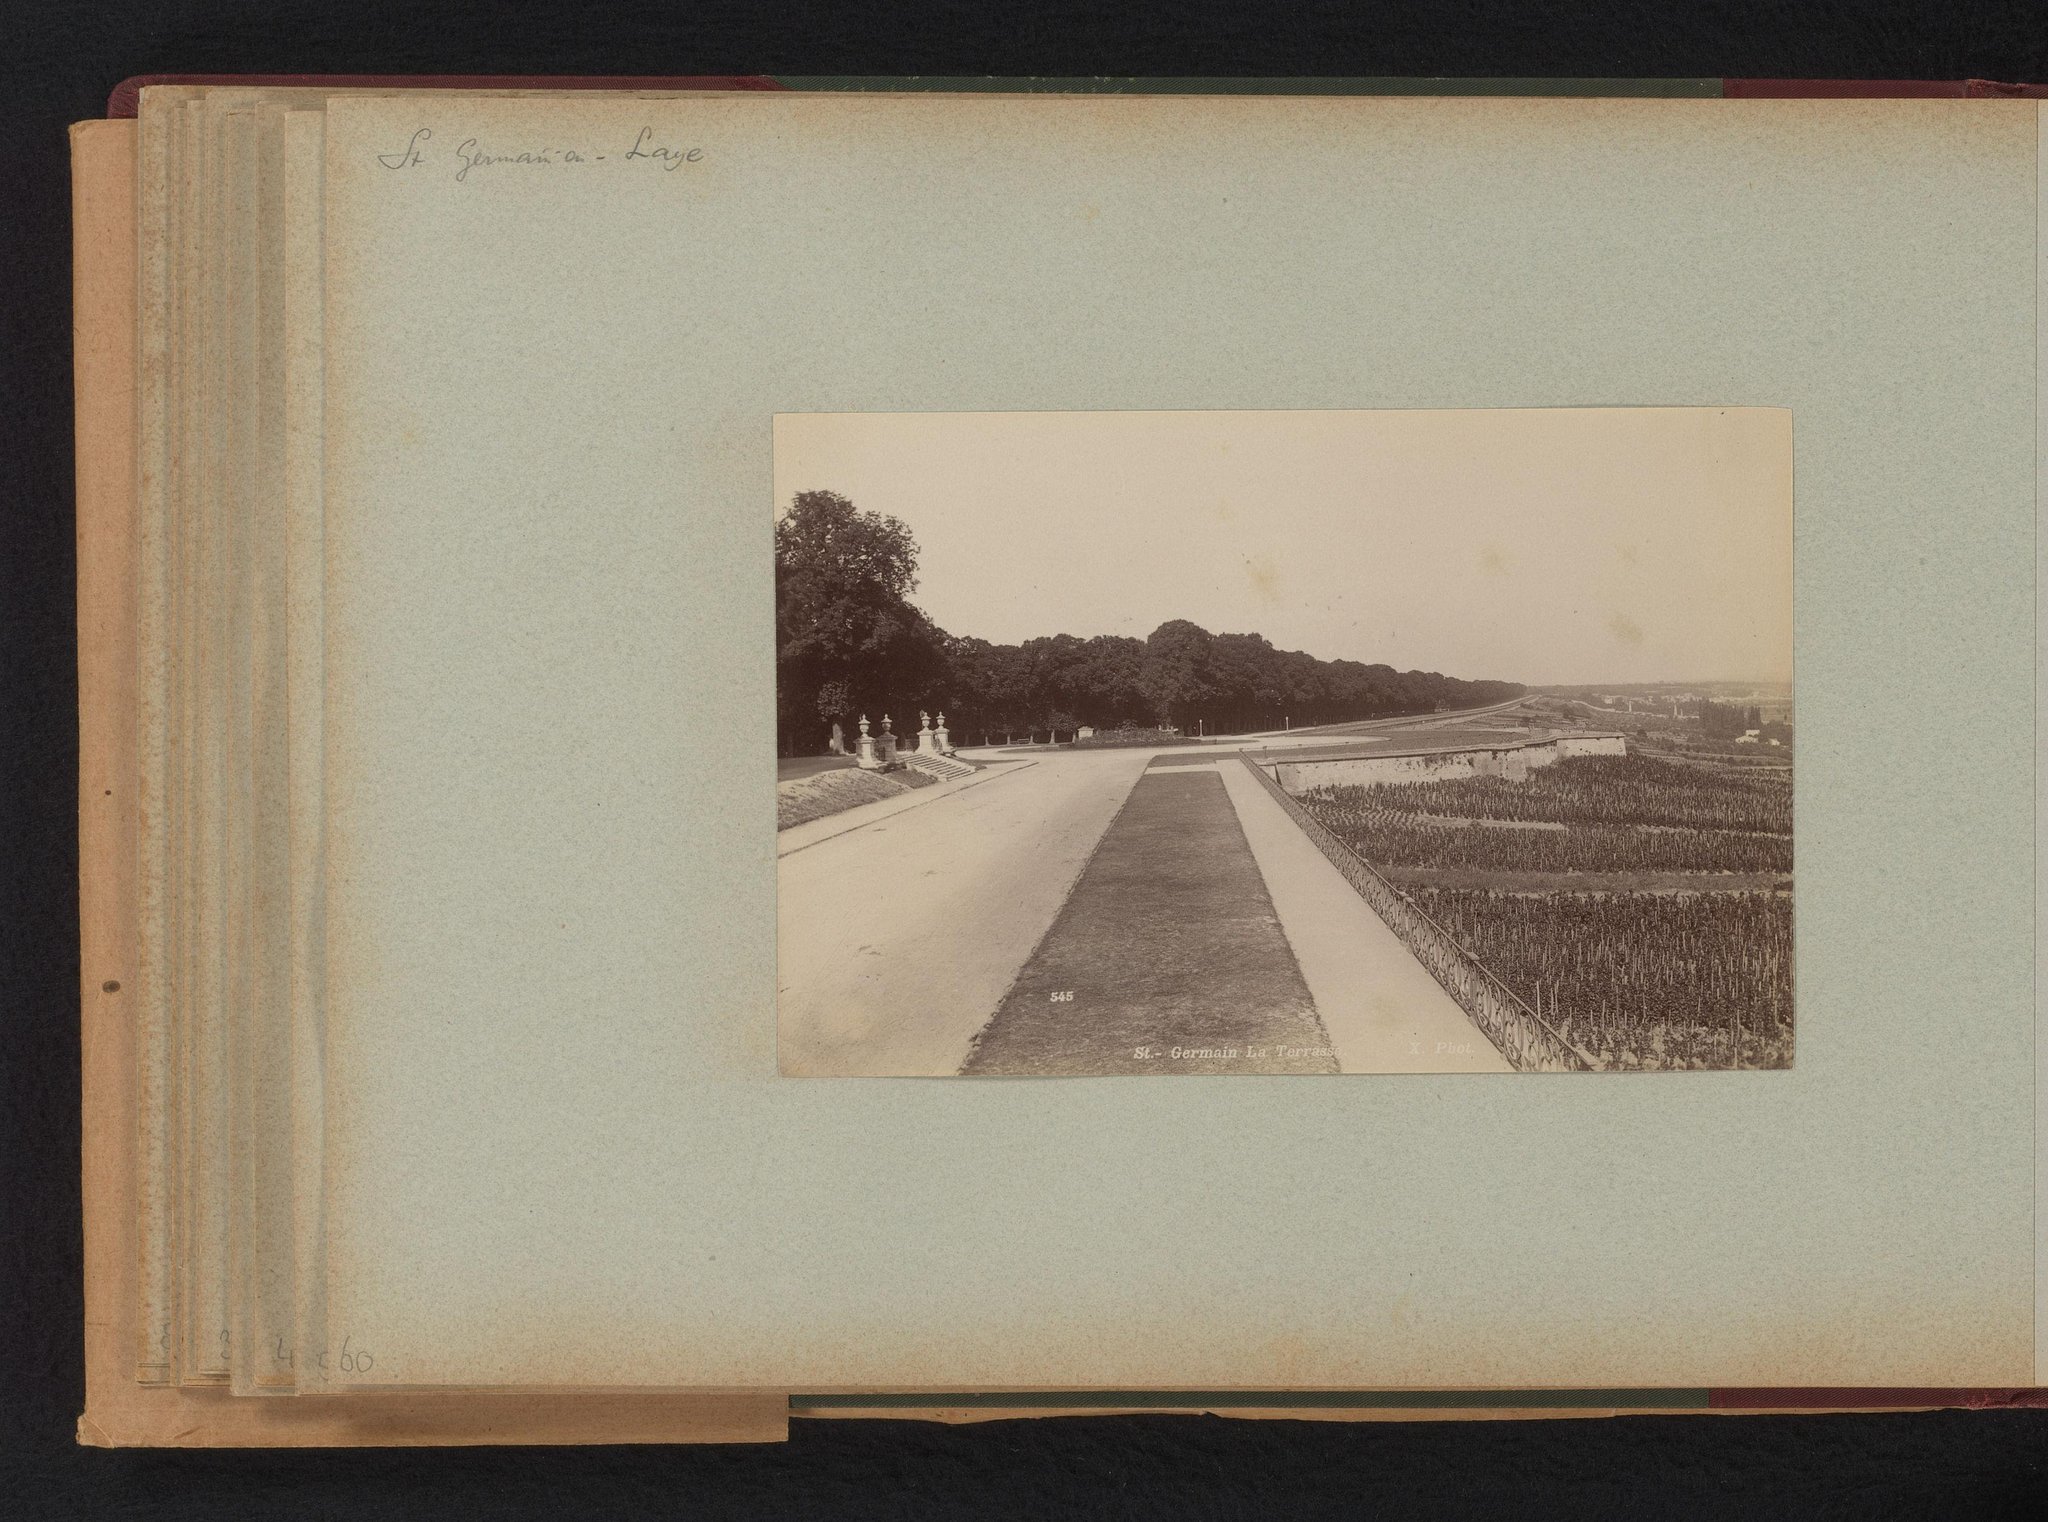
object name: album leaf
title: Gezicht op de tuinen van het kasteel van Saint-Germain-en-Laye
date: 1887-1900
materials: paper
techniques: albumen print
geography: saint-germain-en-laye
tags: french or architectonic garden; formal garden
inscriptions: number: ‘545’, inscription: ‘St Germain-a-Laye’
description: Tussen 1887 en ca. 1900 werkten Neurdein frères onder andere onder de naam 'X phot.'.